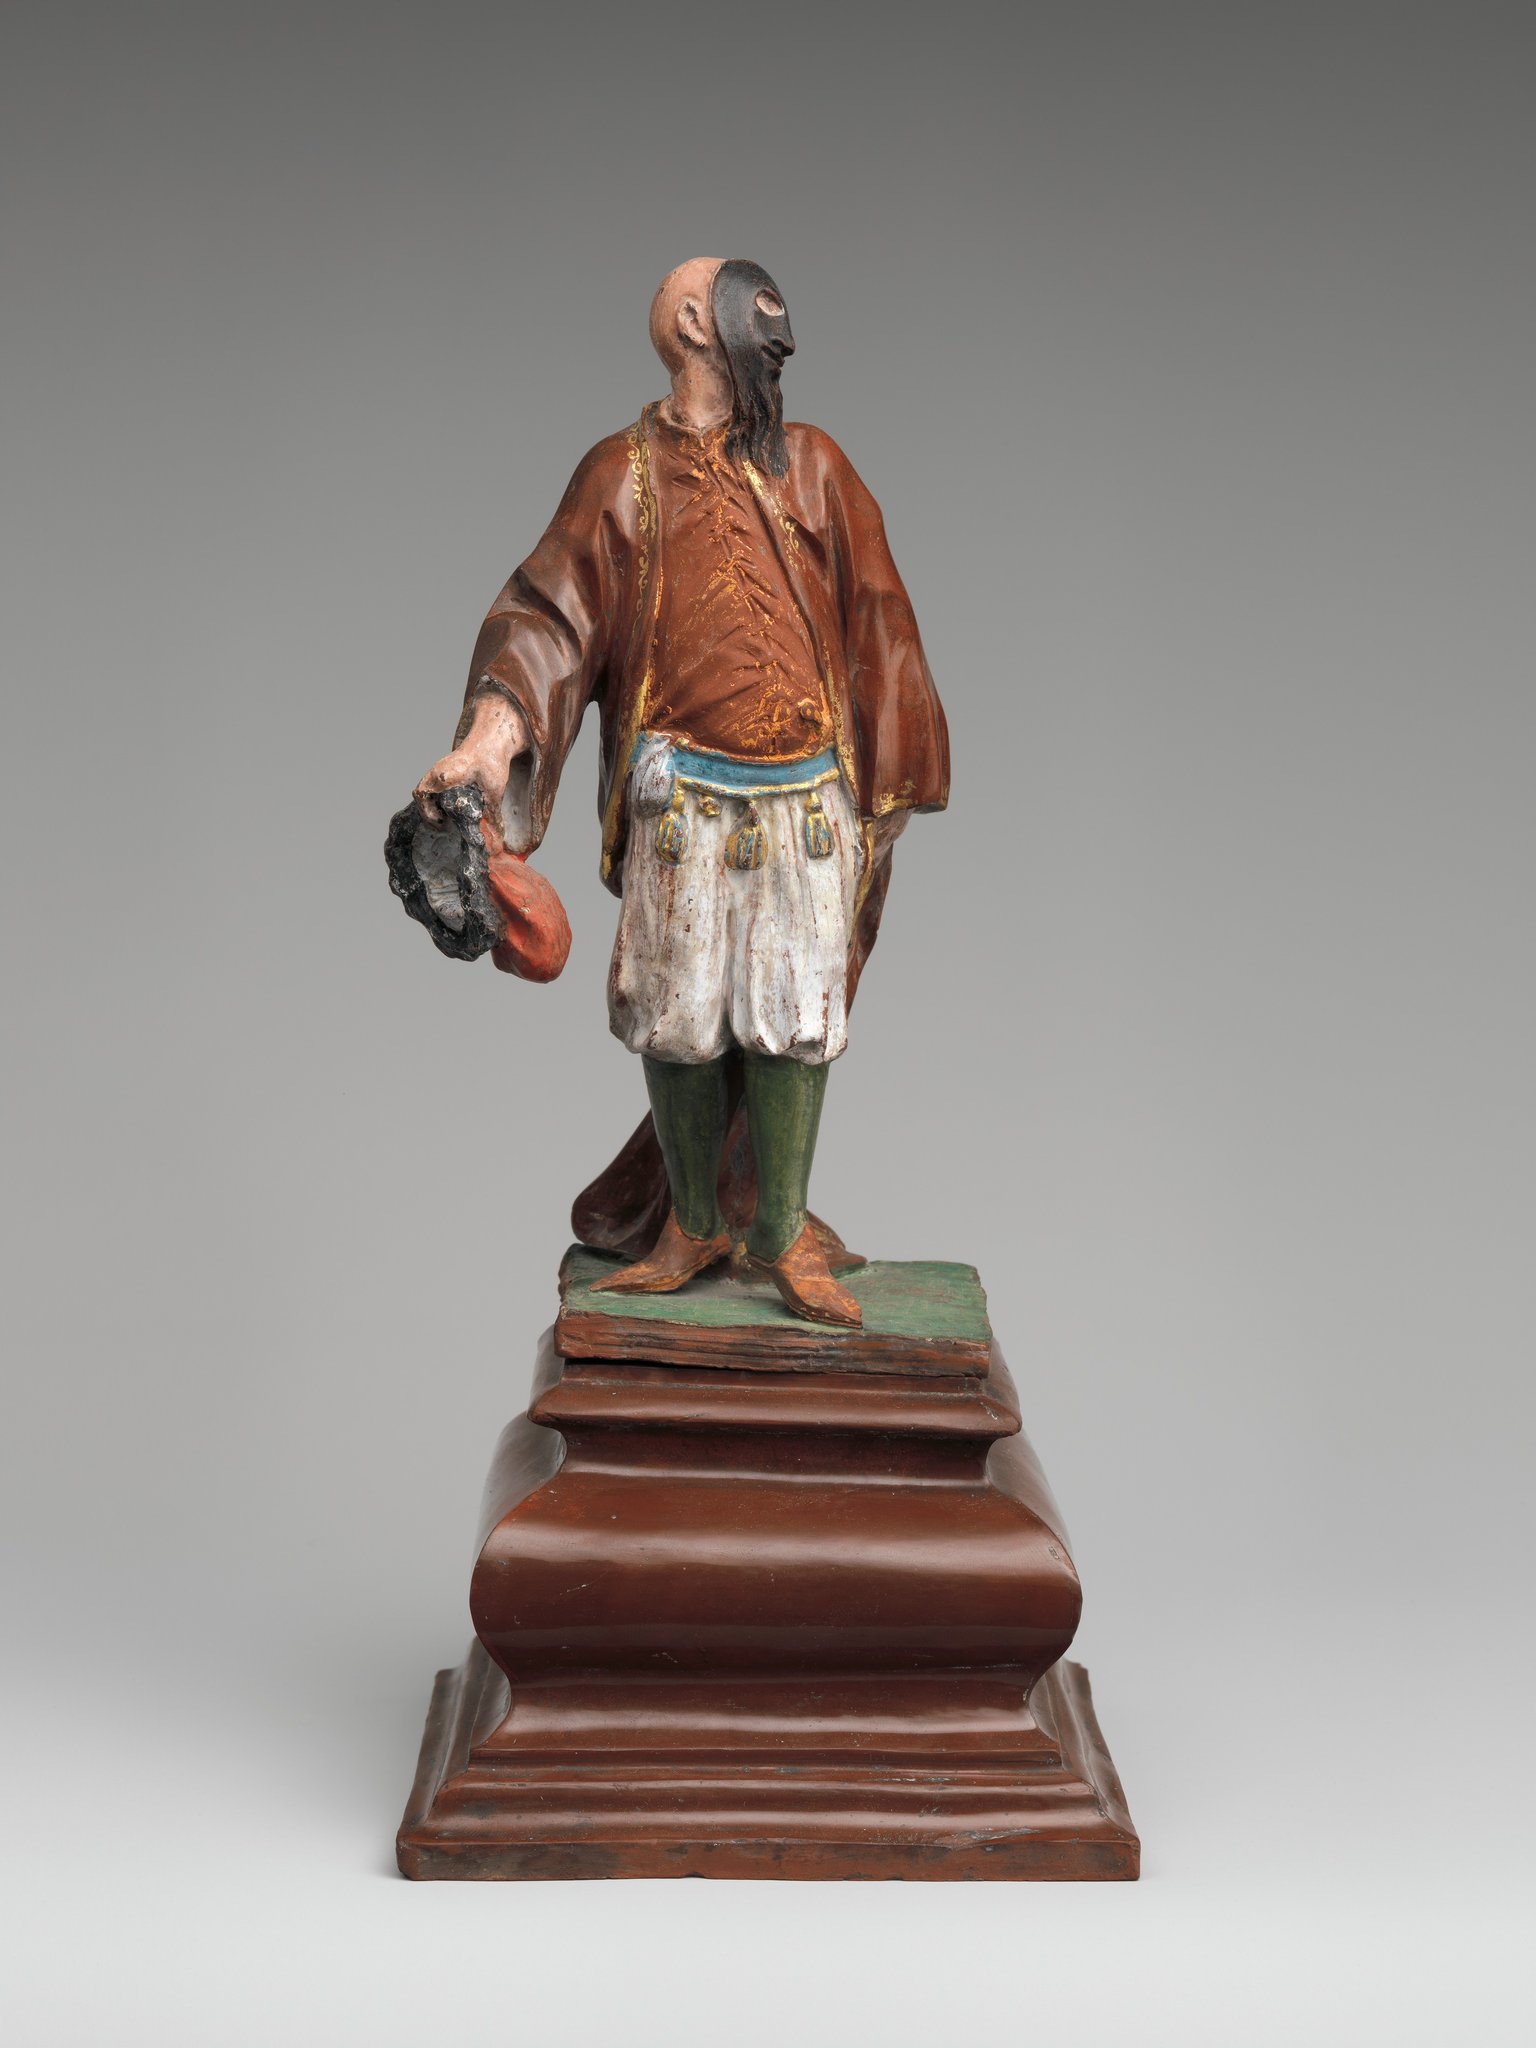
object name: figure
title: Brighella on a pedestal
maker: meissen manufactory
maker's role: manufactory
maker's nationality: german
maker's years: 1710-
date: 1710-1713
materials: stoneware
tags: masks,men